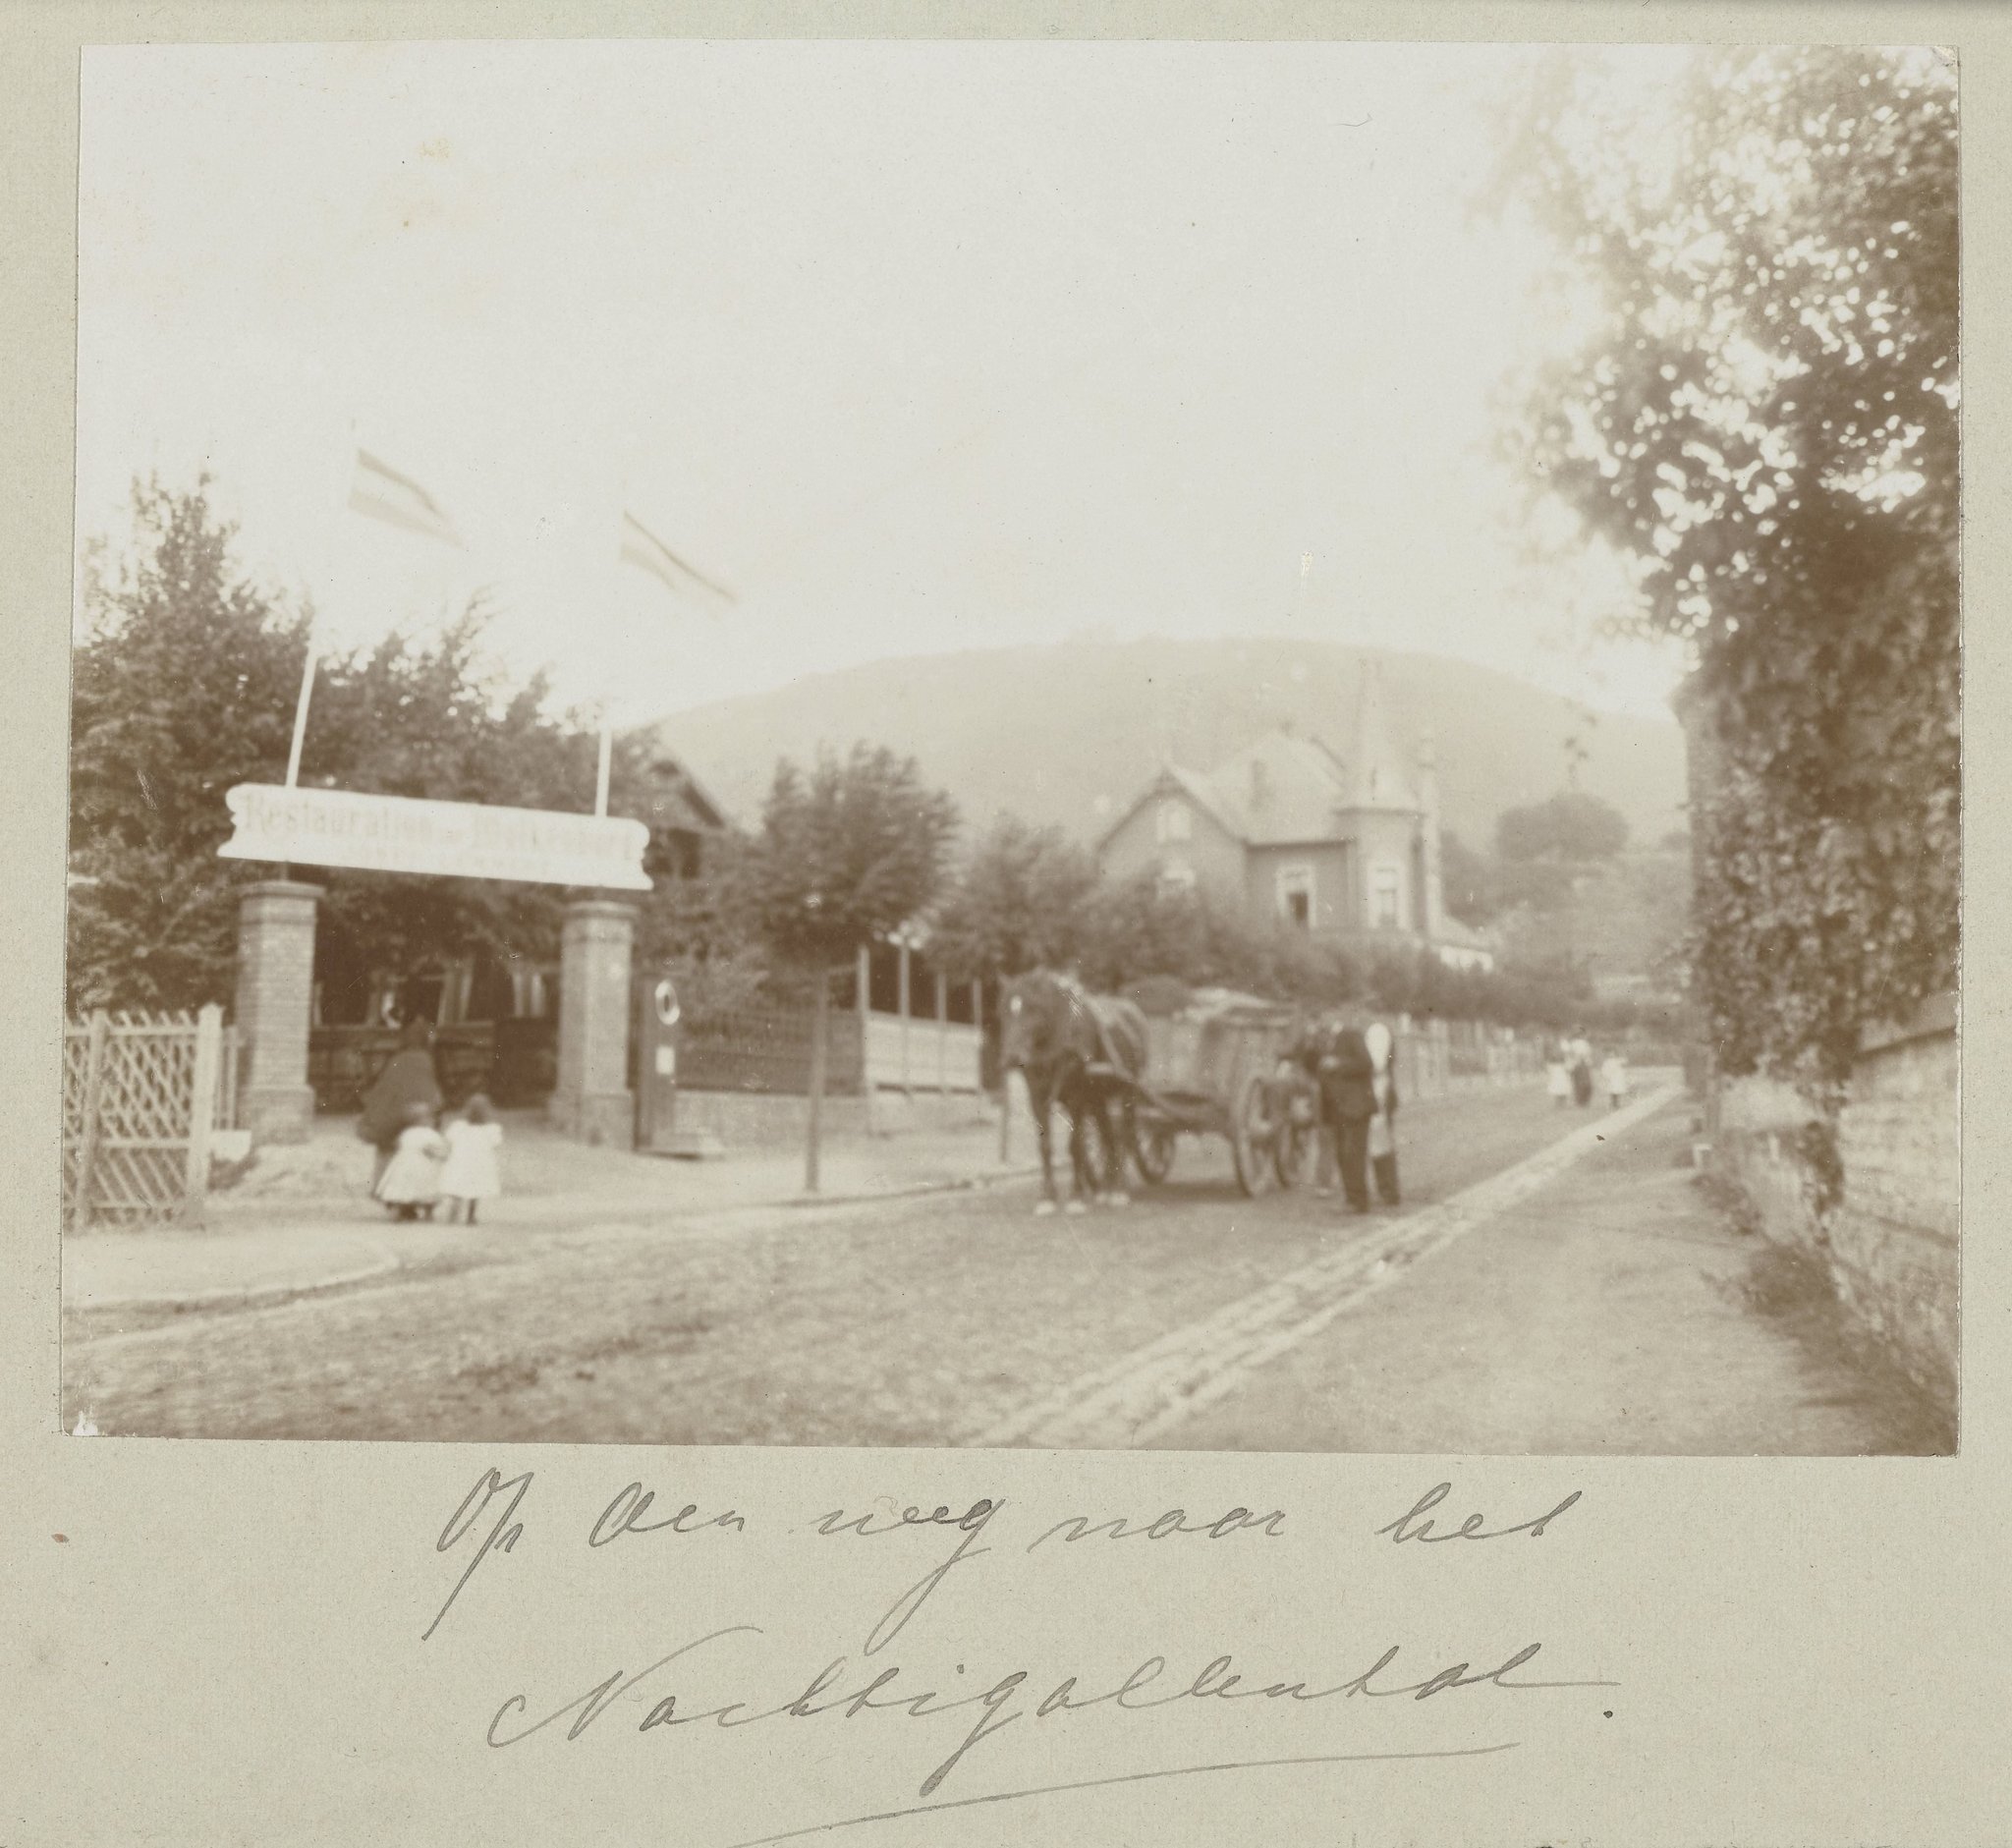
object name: photograph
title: Straatgezicht met een paard-en-wagen, Königswinter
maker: david vermeulen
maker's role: fotograaf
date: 1895-1905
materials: paper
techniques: collodion silver print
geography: königswinter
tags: four-wheeled vehicle drawn by one animal, street